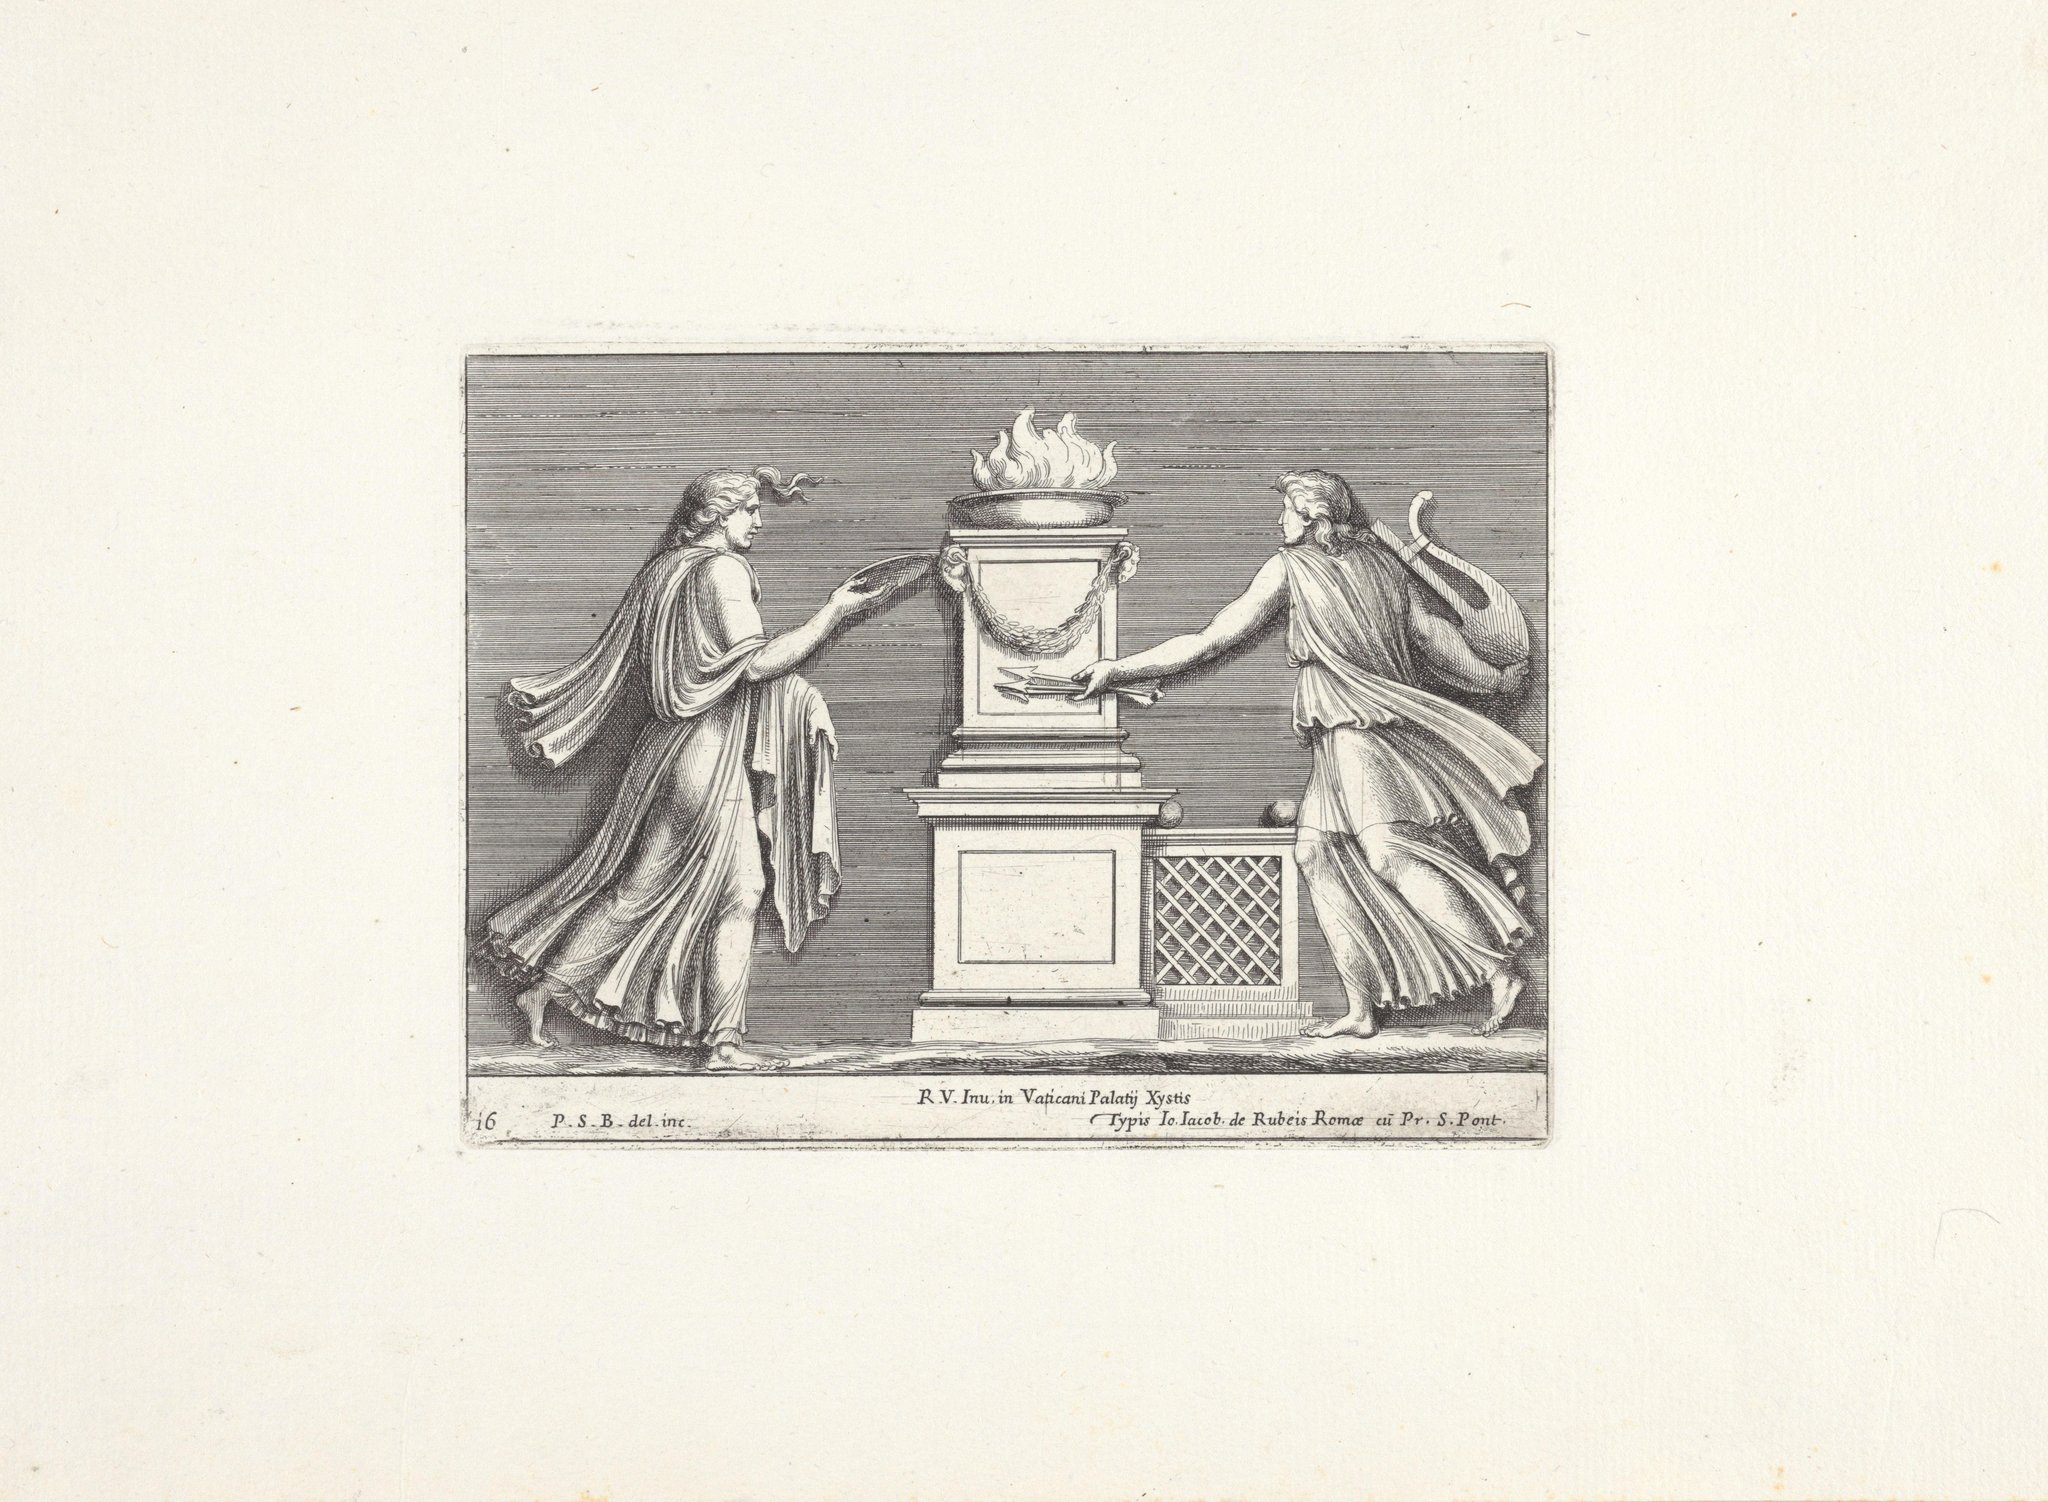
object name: print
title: Offerritueel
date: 1645-1700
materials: paper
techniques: engraving, etching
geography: italy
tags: sacrifice ~ roman religion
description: Prent uit een reeks naar de gipsen reliëfs door Rafaël en uitgevoerd door zijn assistenten in de Vaticaanse Loggia.